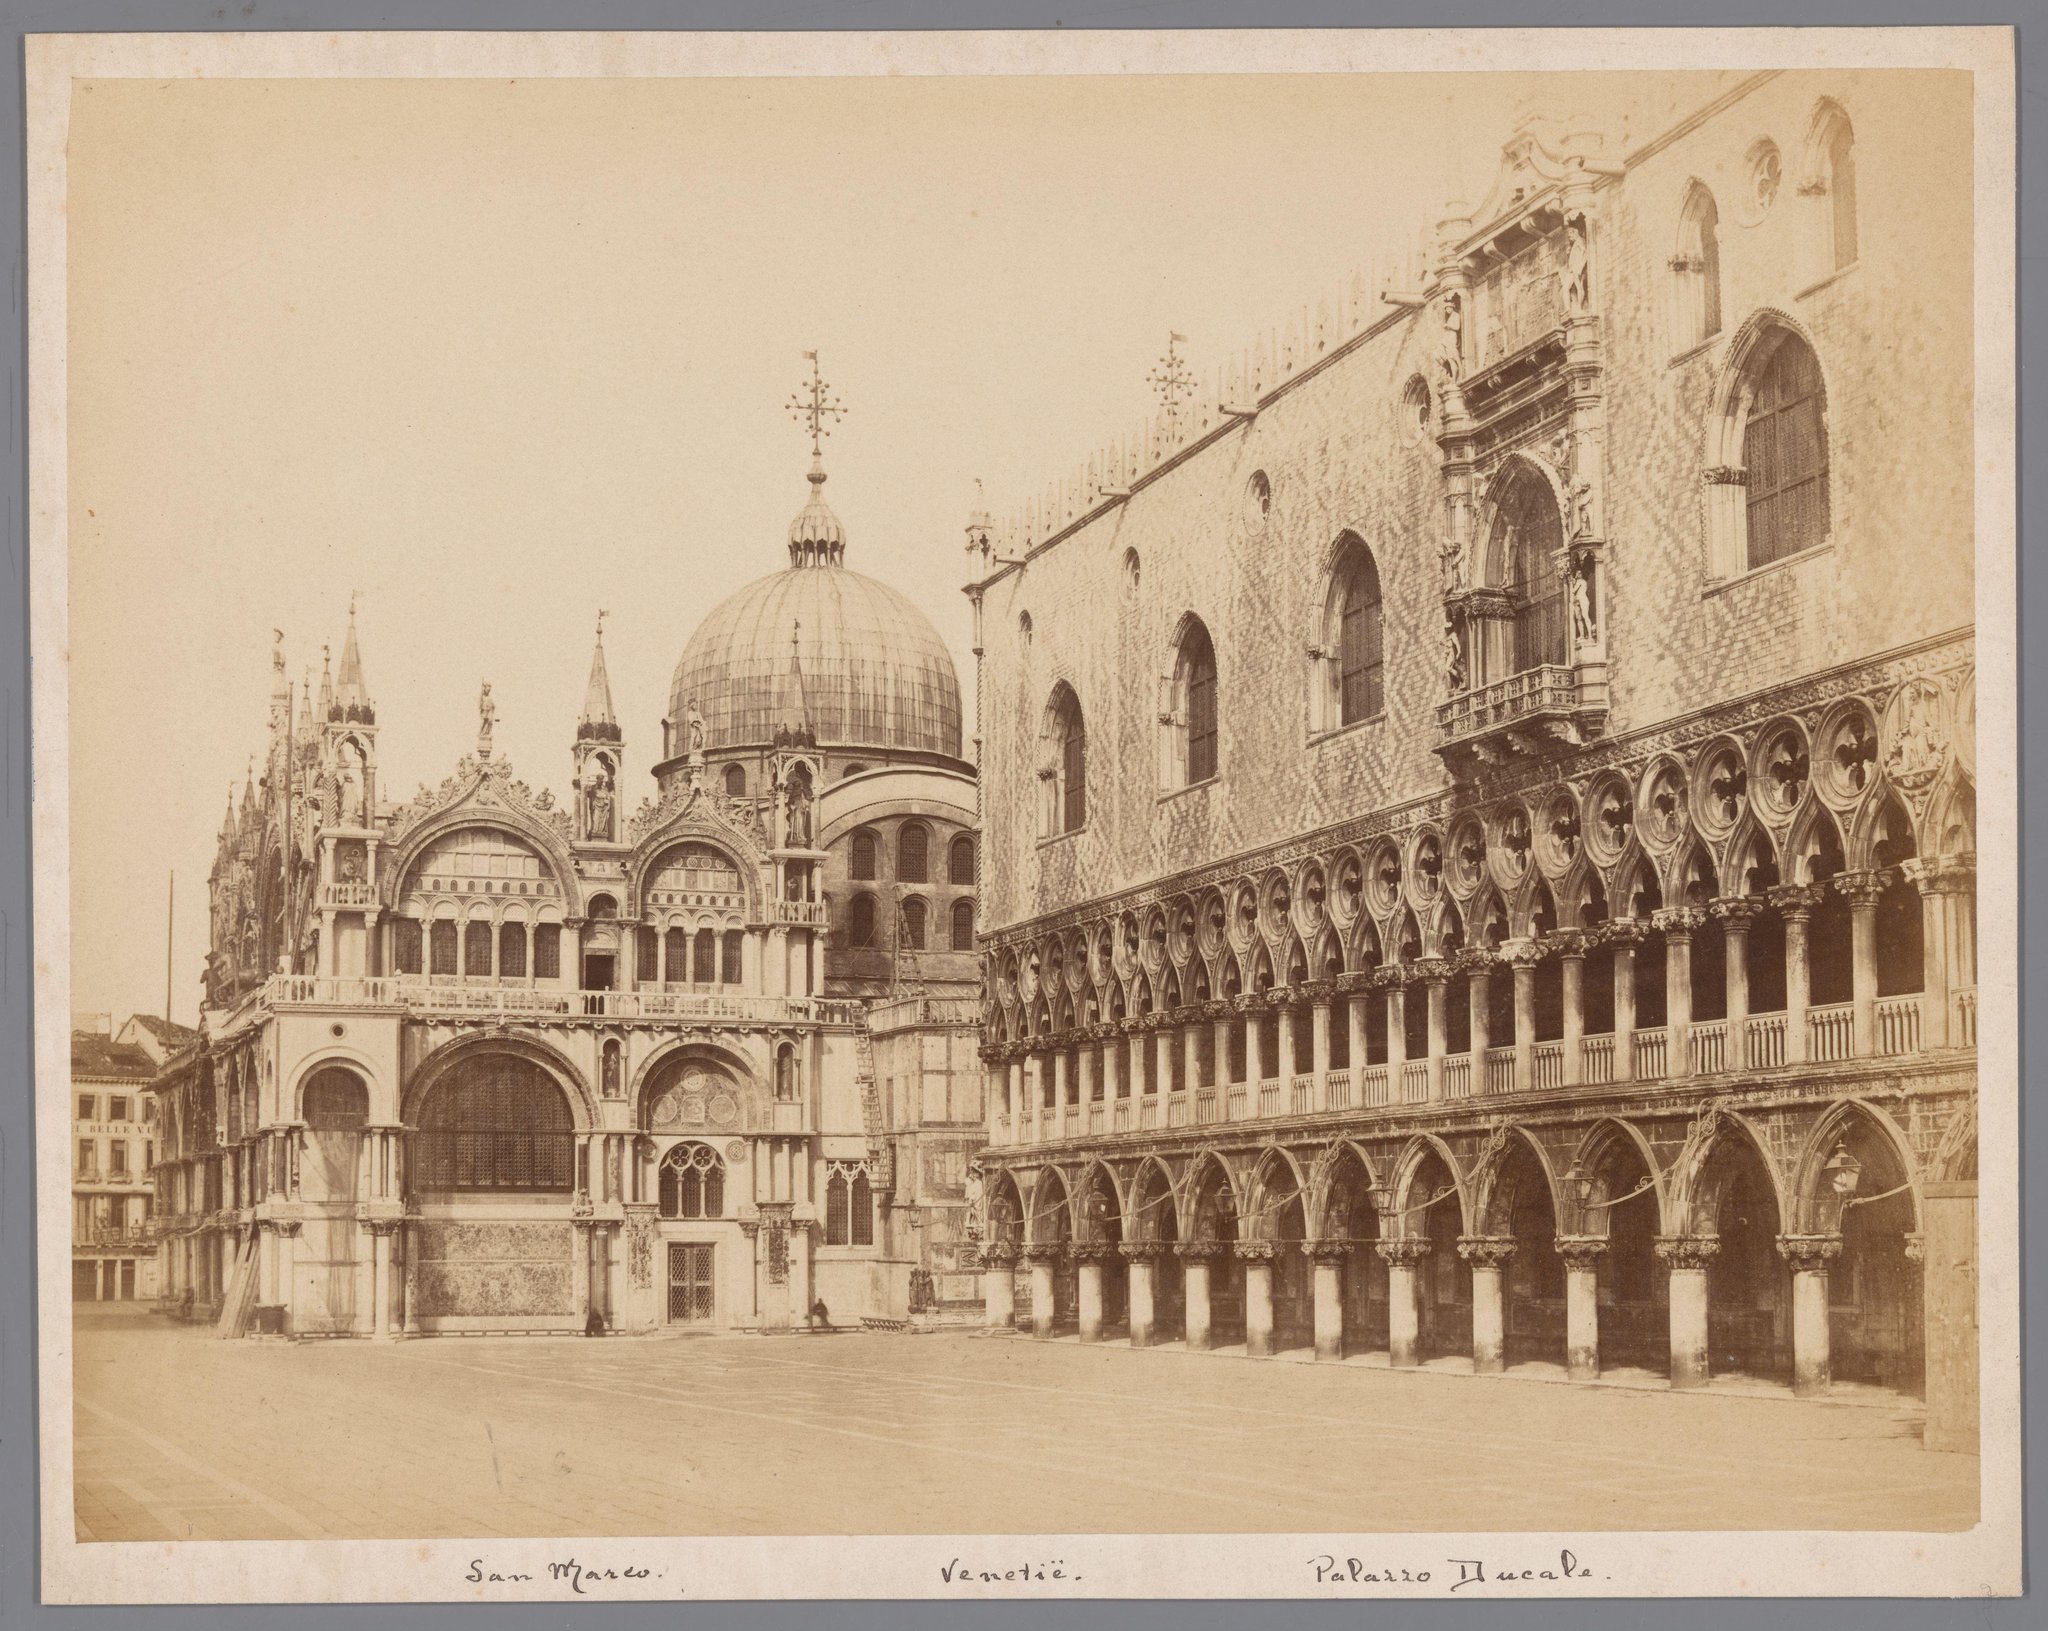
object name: photograph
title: San Marco. Venetie. Palazzo Ducale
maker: Anonymous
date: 1851-1900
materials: cardboard, paper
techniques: albumen print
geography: venice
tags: square, place, circus, etc., church (exterior), façade (of house or building)